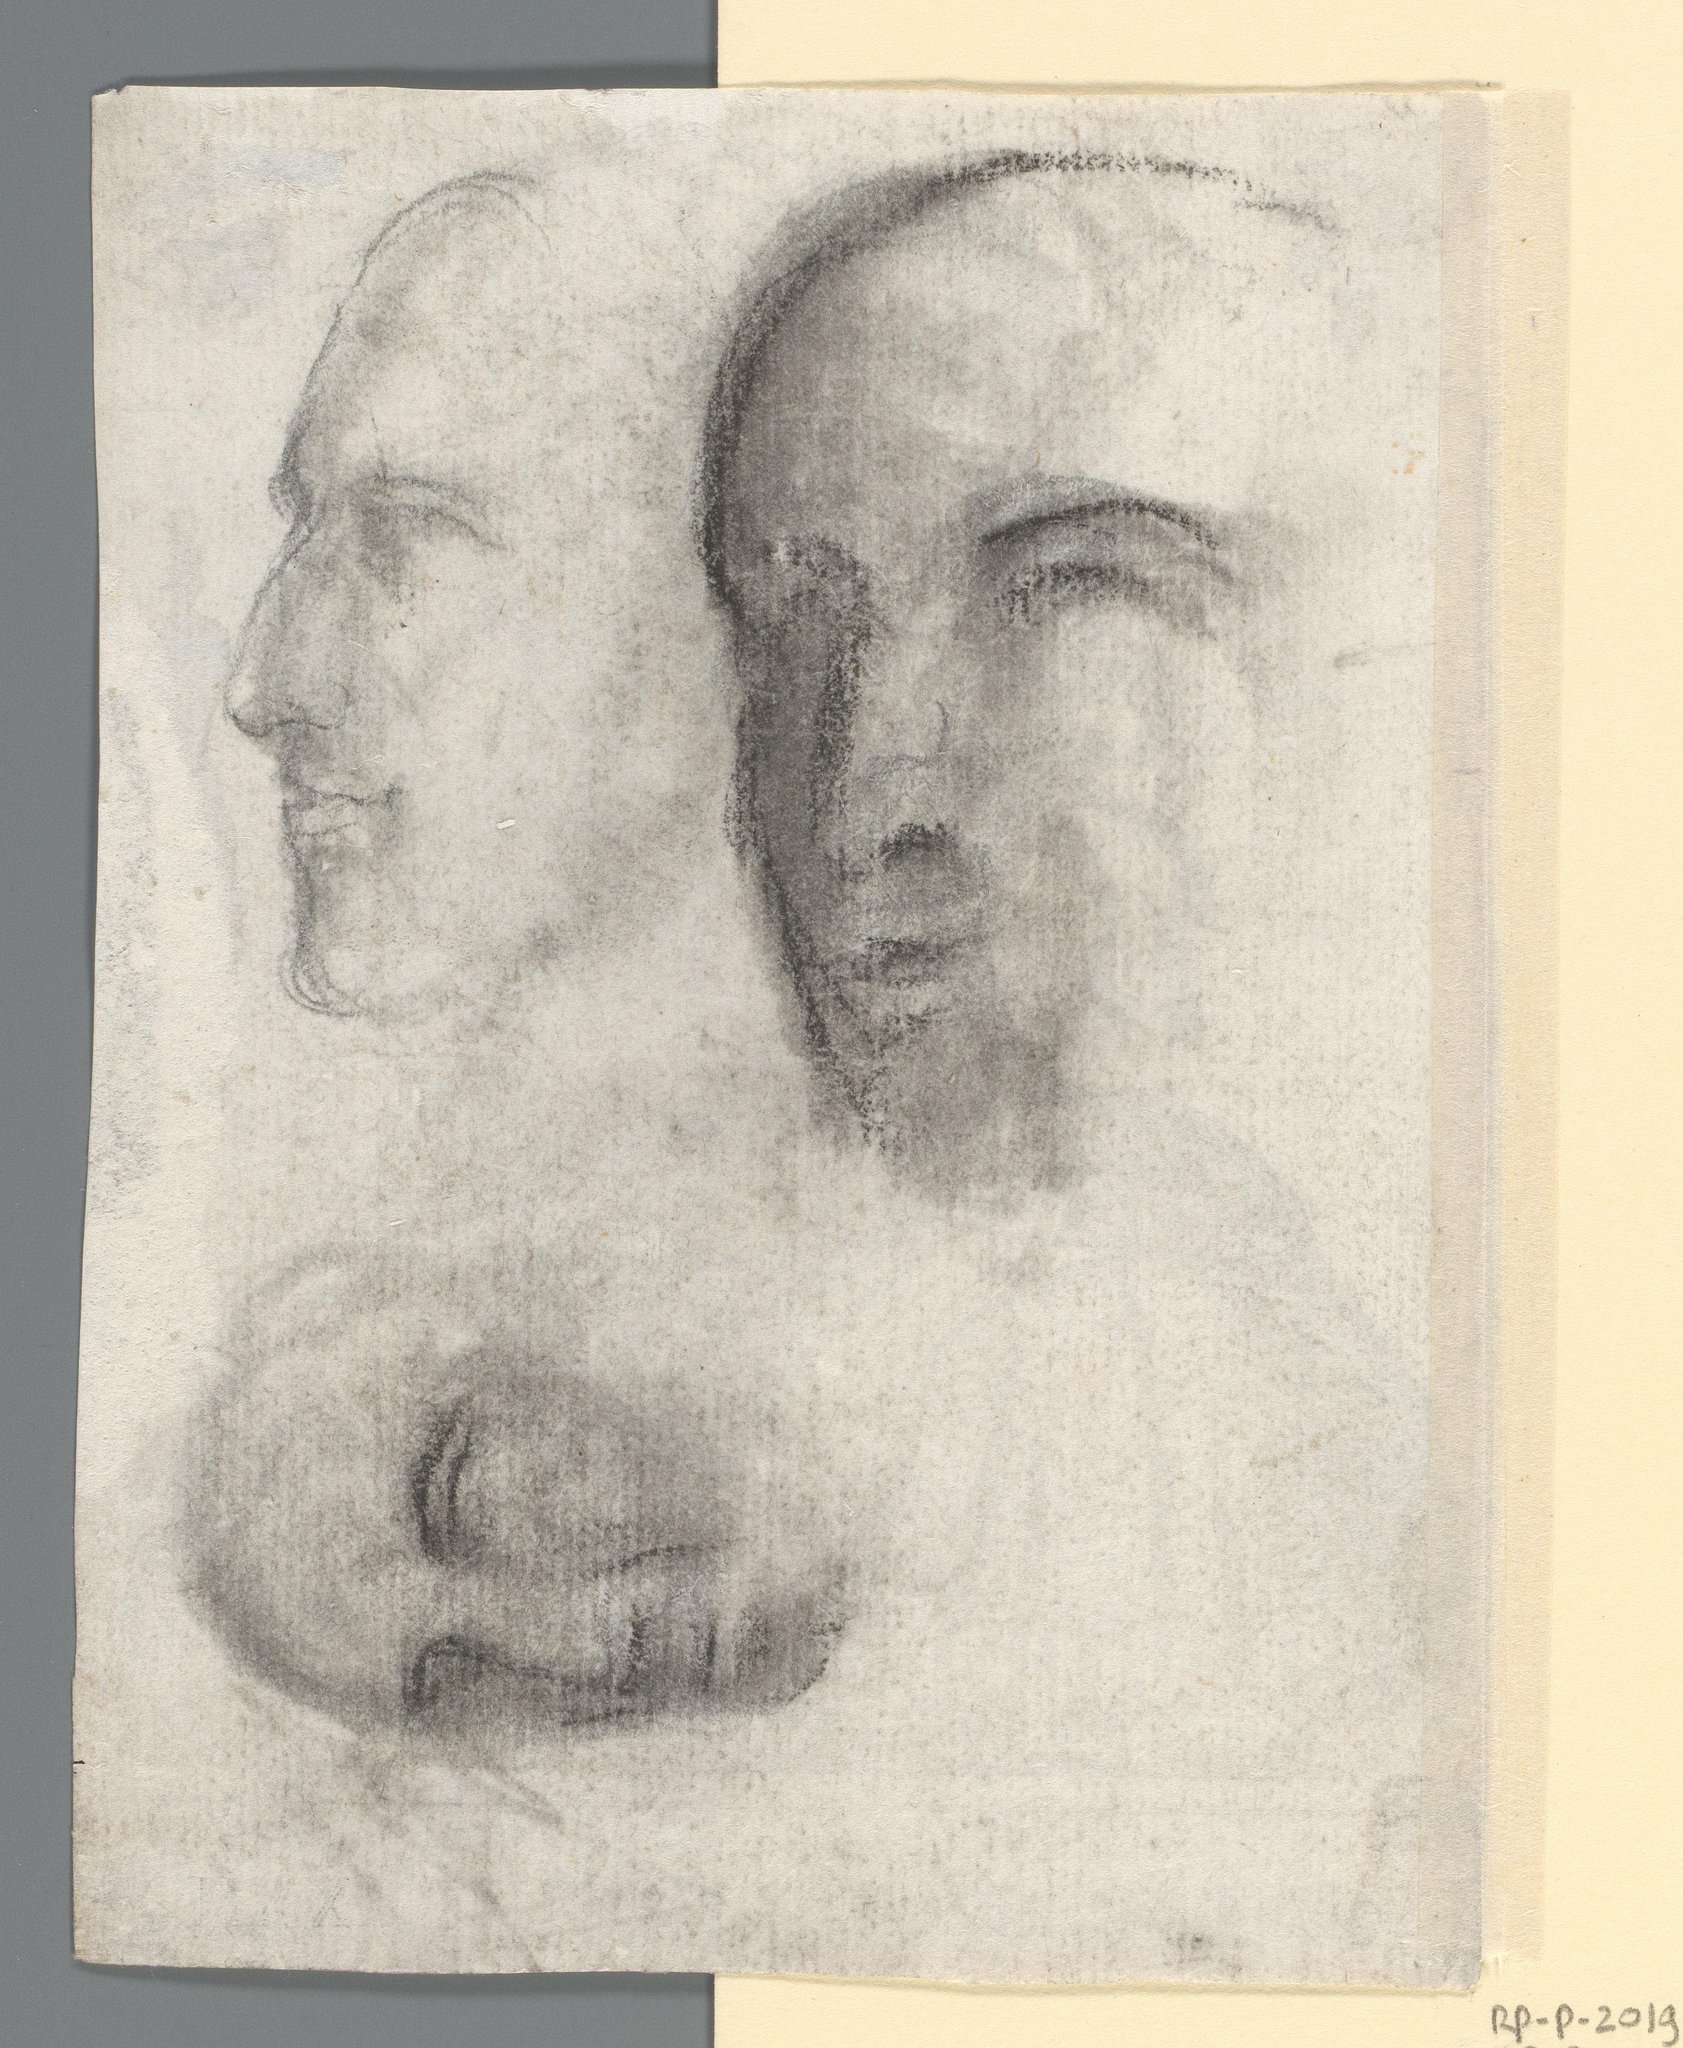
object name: drawing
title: Studie van drie gezichten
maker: Anonymous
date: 1750-1820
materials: chalk, paper, pencil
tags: standing figure, standing figure - aa - female human figure, dress, gown